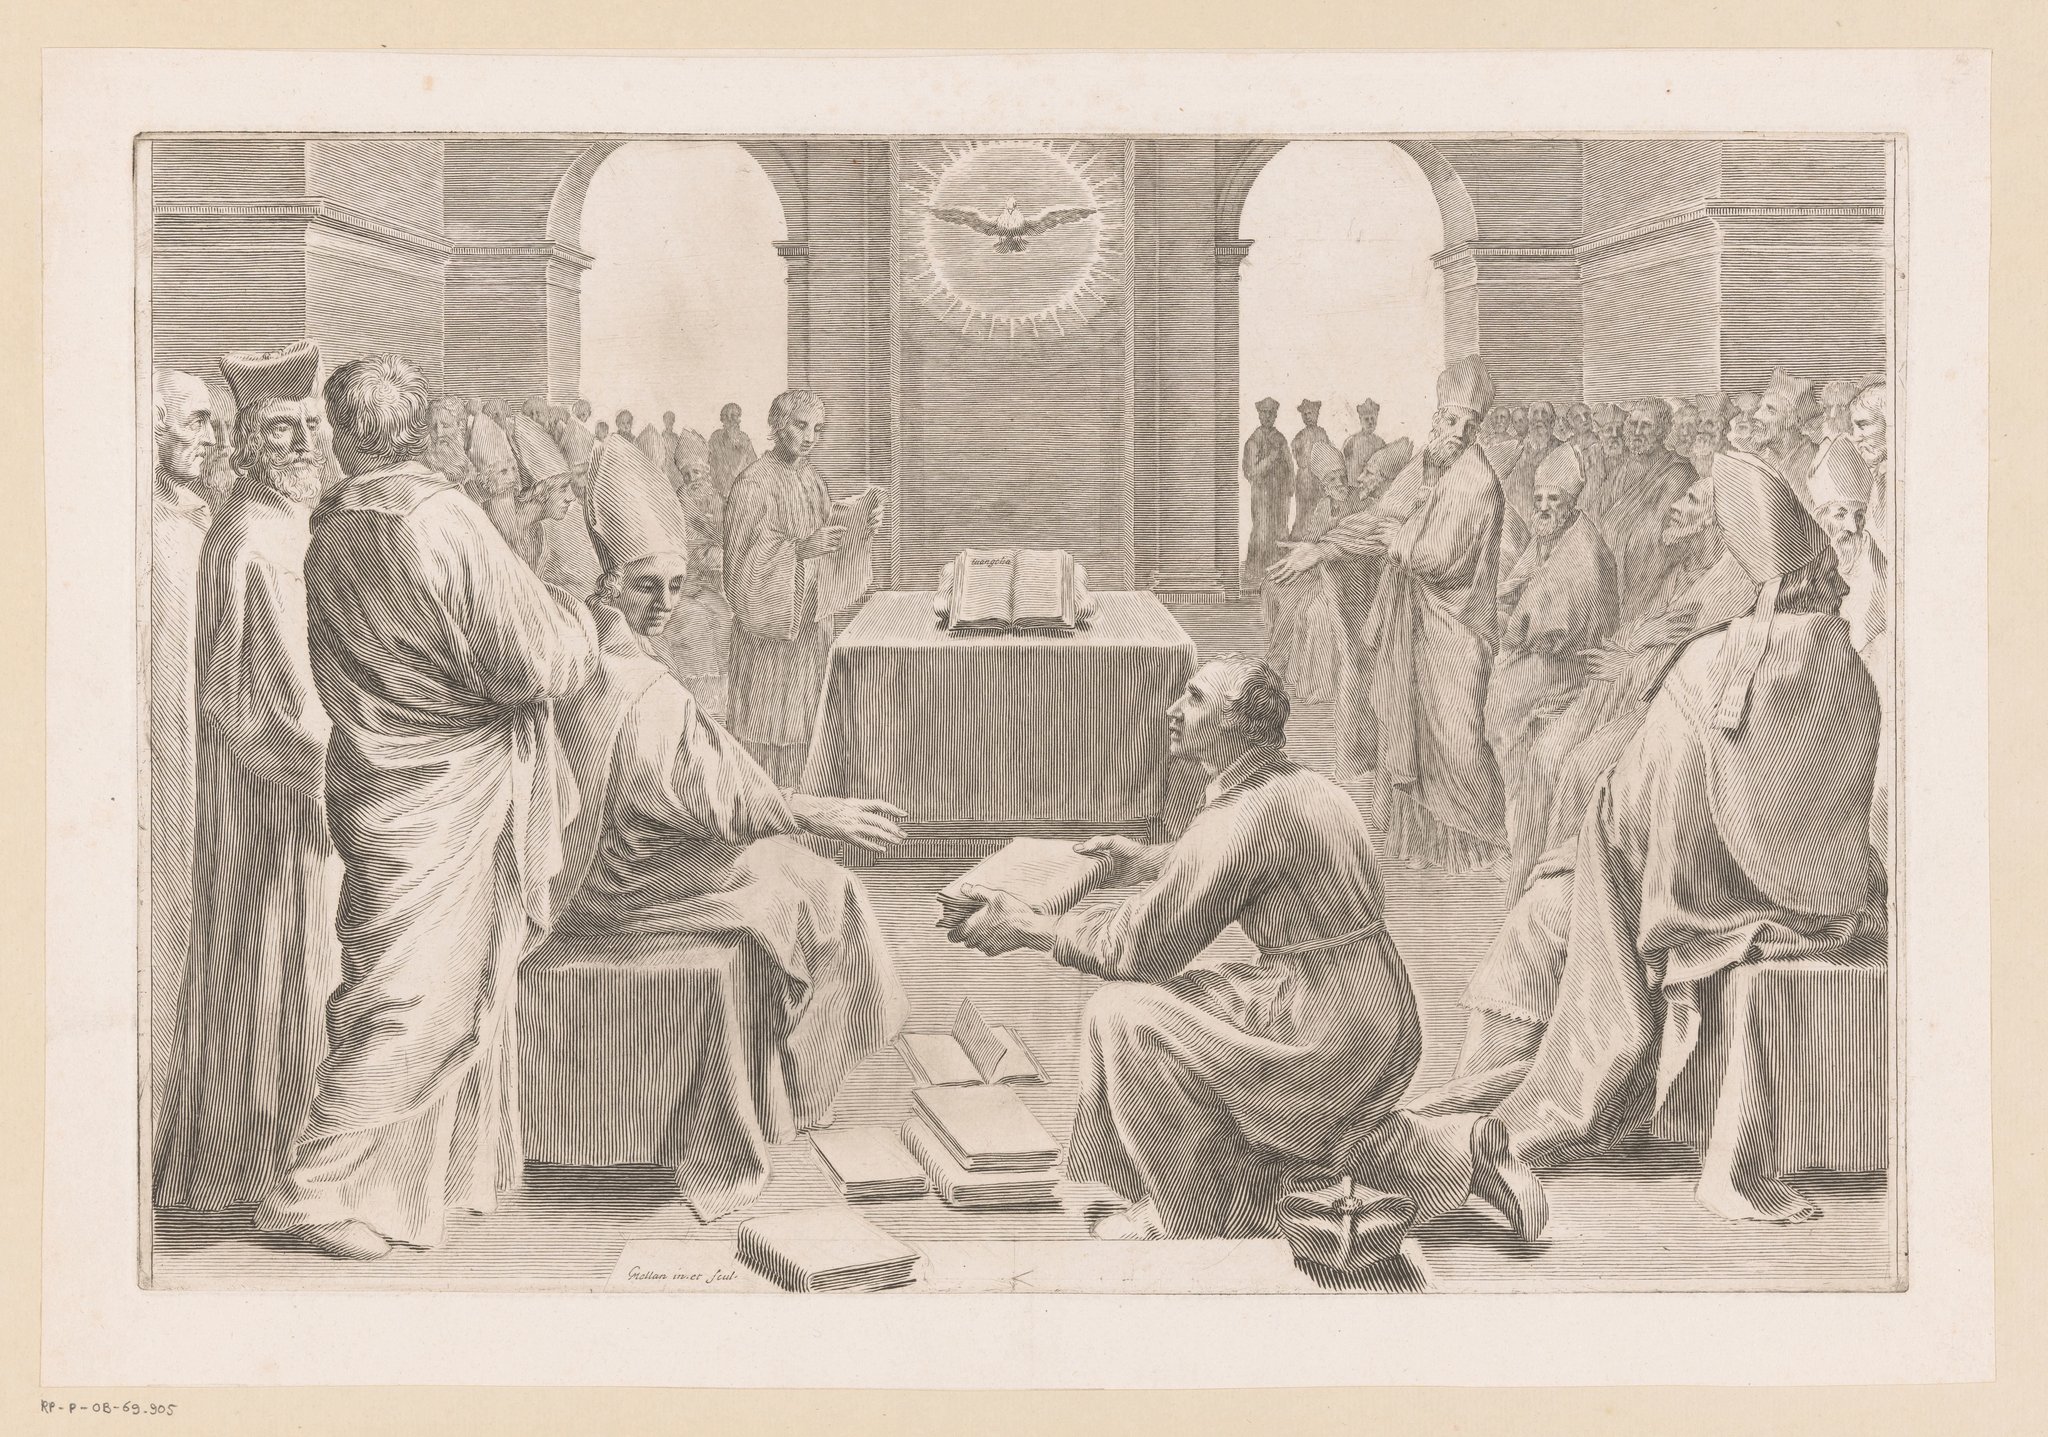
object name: print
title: Concilie met de Heilige Geest boven het Evangelie, omringd door geestelijken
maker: claude mellan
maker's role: draughtsman, print maker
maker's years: 1598-1688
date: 1665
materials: paper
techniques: engraving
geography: france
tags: council, synod ~ roman catholic church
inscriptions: collector's mark: Lugt 240, watermark